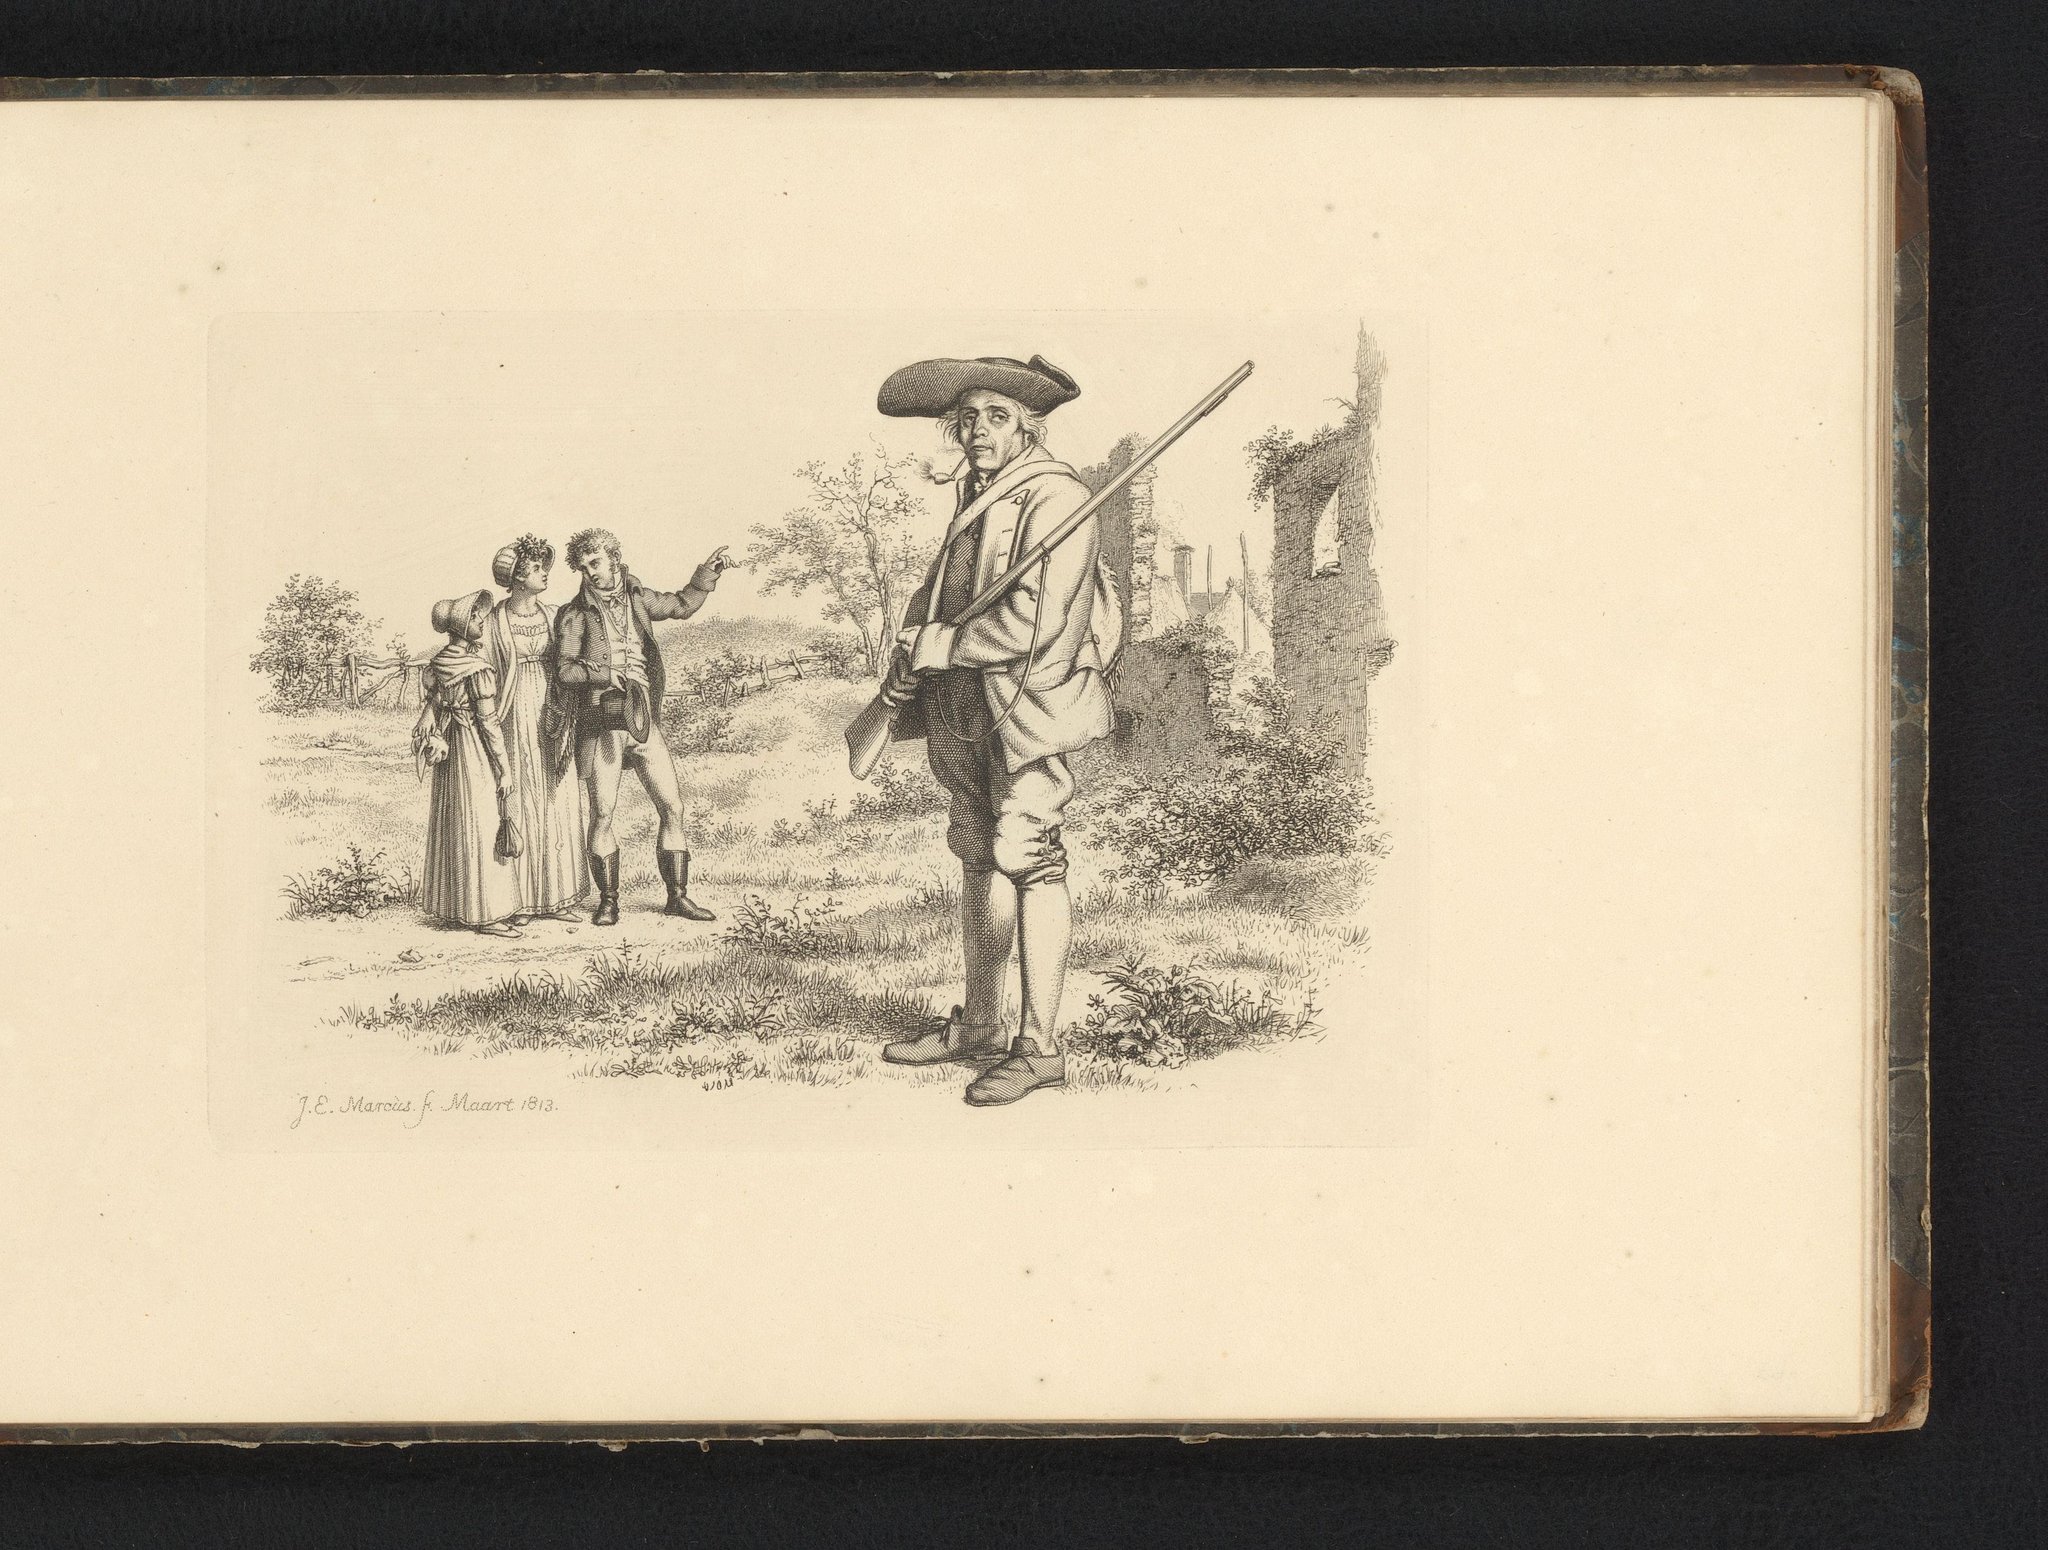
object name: print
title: Landschap met gezin en jager bij een ruïne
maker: jacob ernst marcus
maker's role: draughtsman, print maker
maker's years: 1774-1826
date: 1803-1813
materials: paper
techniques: etching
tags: parents with their children, hunter, landscape with ruins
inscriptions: date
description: Deze prent maakt deel uit van een album.